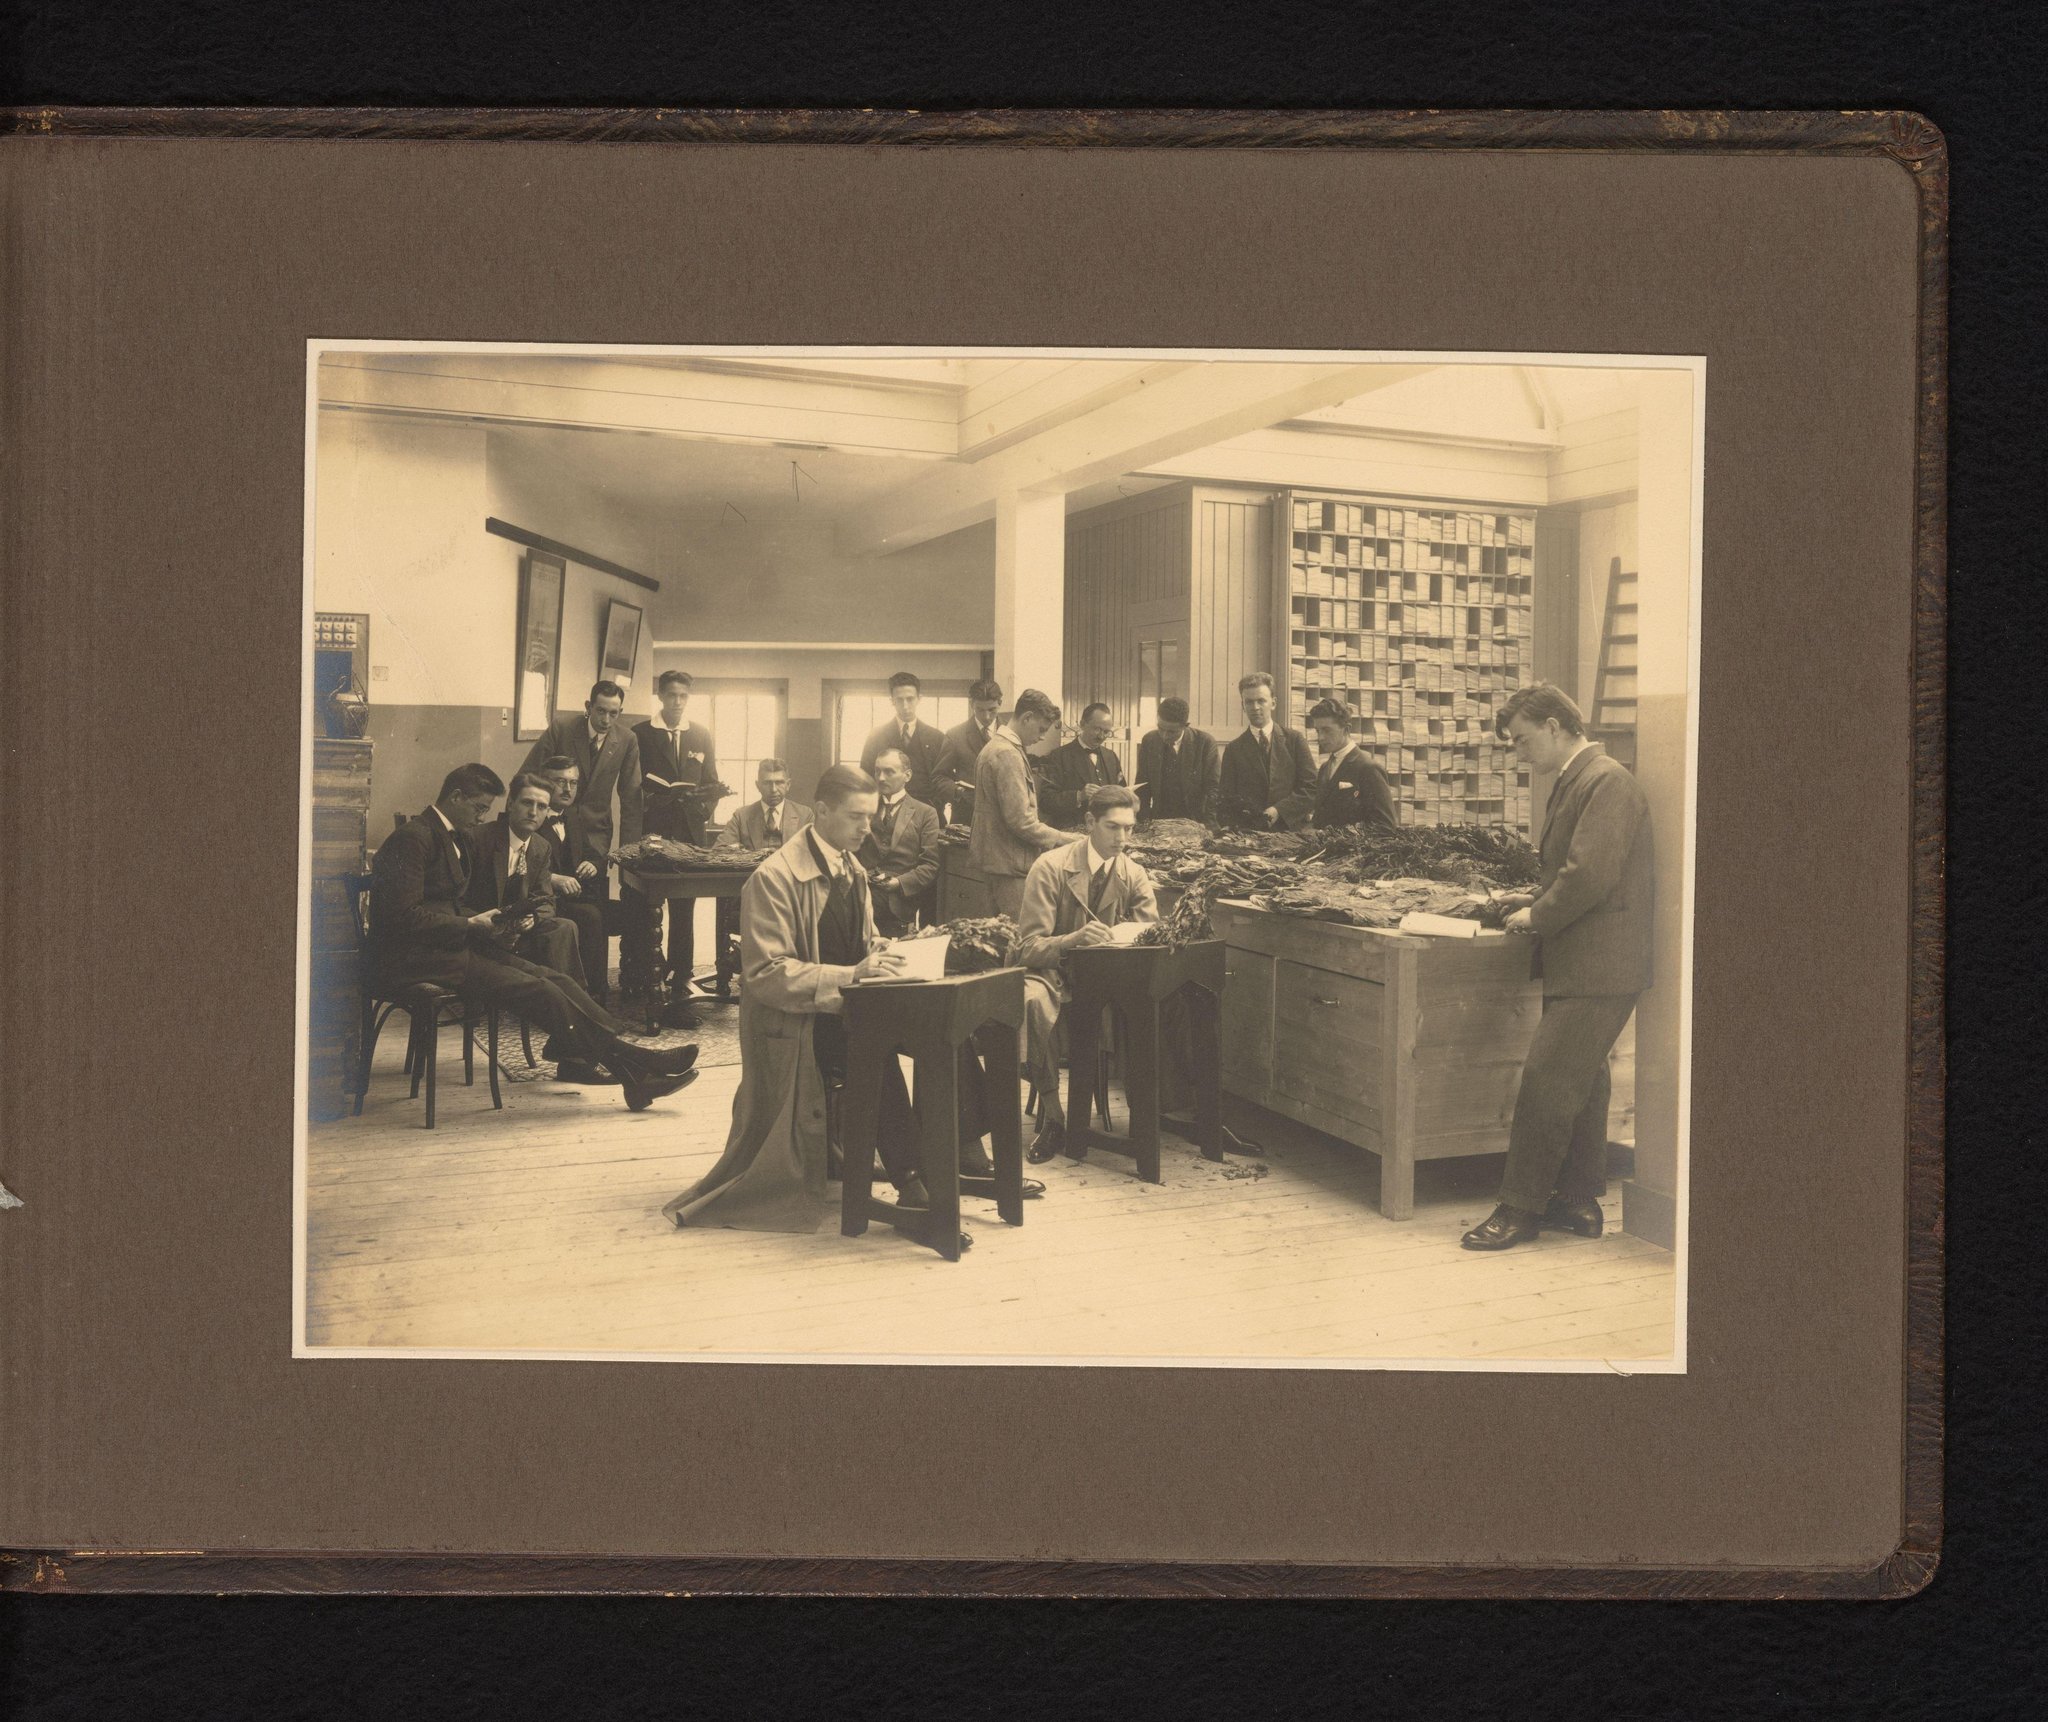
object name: photograph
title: Groep mannen controleert tabak in een pakhuis, vermoedelijk N.V. Het Nederlandsche Veem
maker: Anonymous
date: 1900-1930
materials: cardboard, paper, photographic support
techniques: gelatin silver print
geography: amsterdam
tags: adult man (+ more than eight persons), tobacco, control of quality, amsterdam